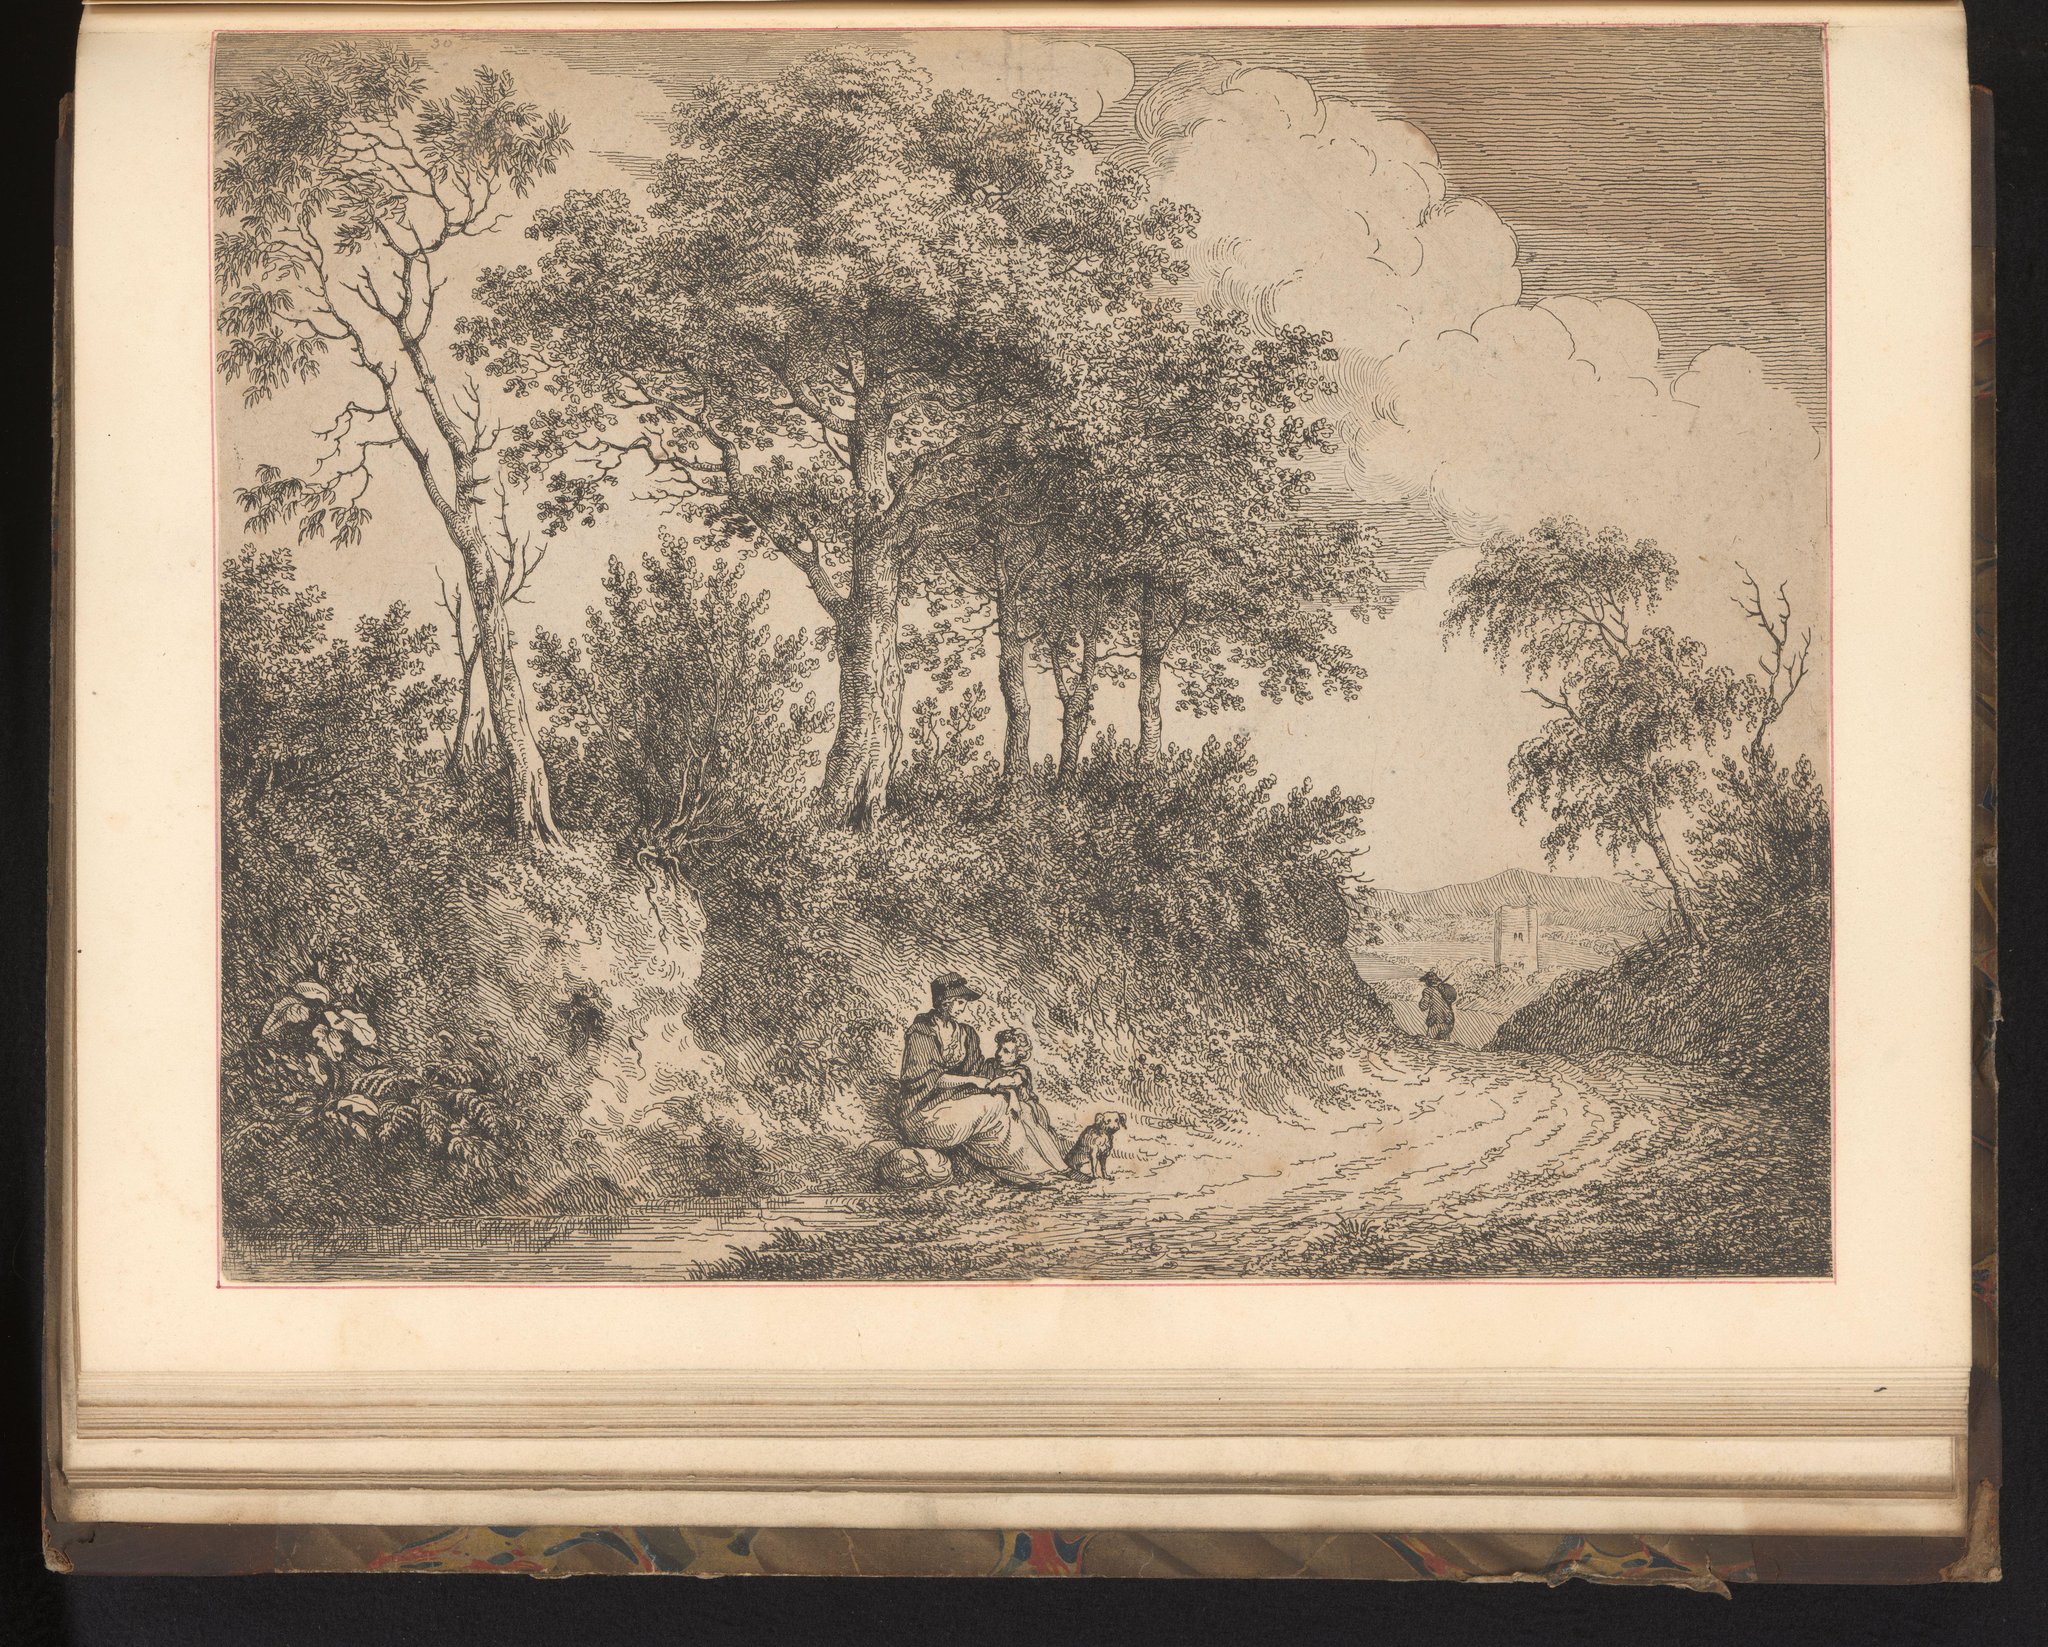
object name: album leaf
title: Etchings by E. Edwards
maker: edward edwards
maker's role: painter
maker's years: 1738-1806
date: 1748-1806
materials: paper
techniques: etching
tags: (traveller) resting in the open air, landscapes (+ landscape with figures, staffage)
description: Prent maakt deel uit van een serie van 51 prenten, bestaande uit twee delen met landschappen (36 prenten) en figuren en portretten (15 prenten), voor het eerst uitgegeven in Londen in 1790.